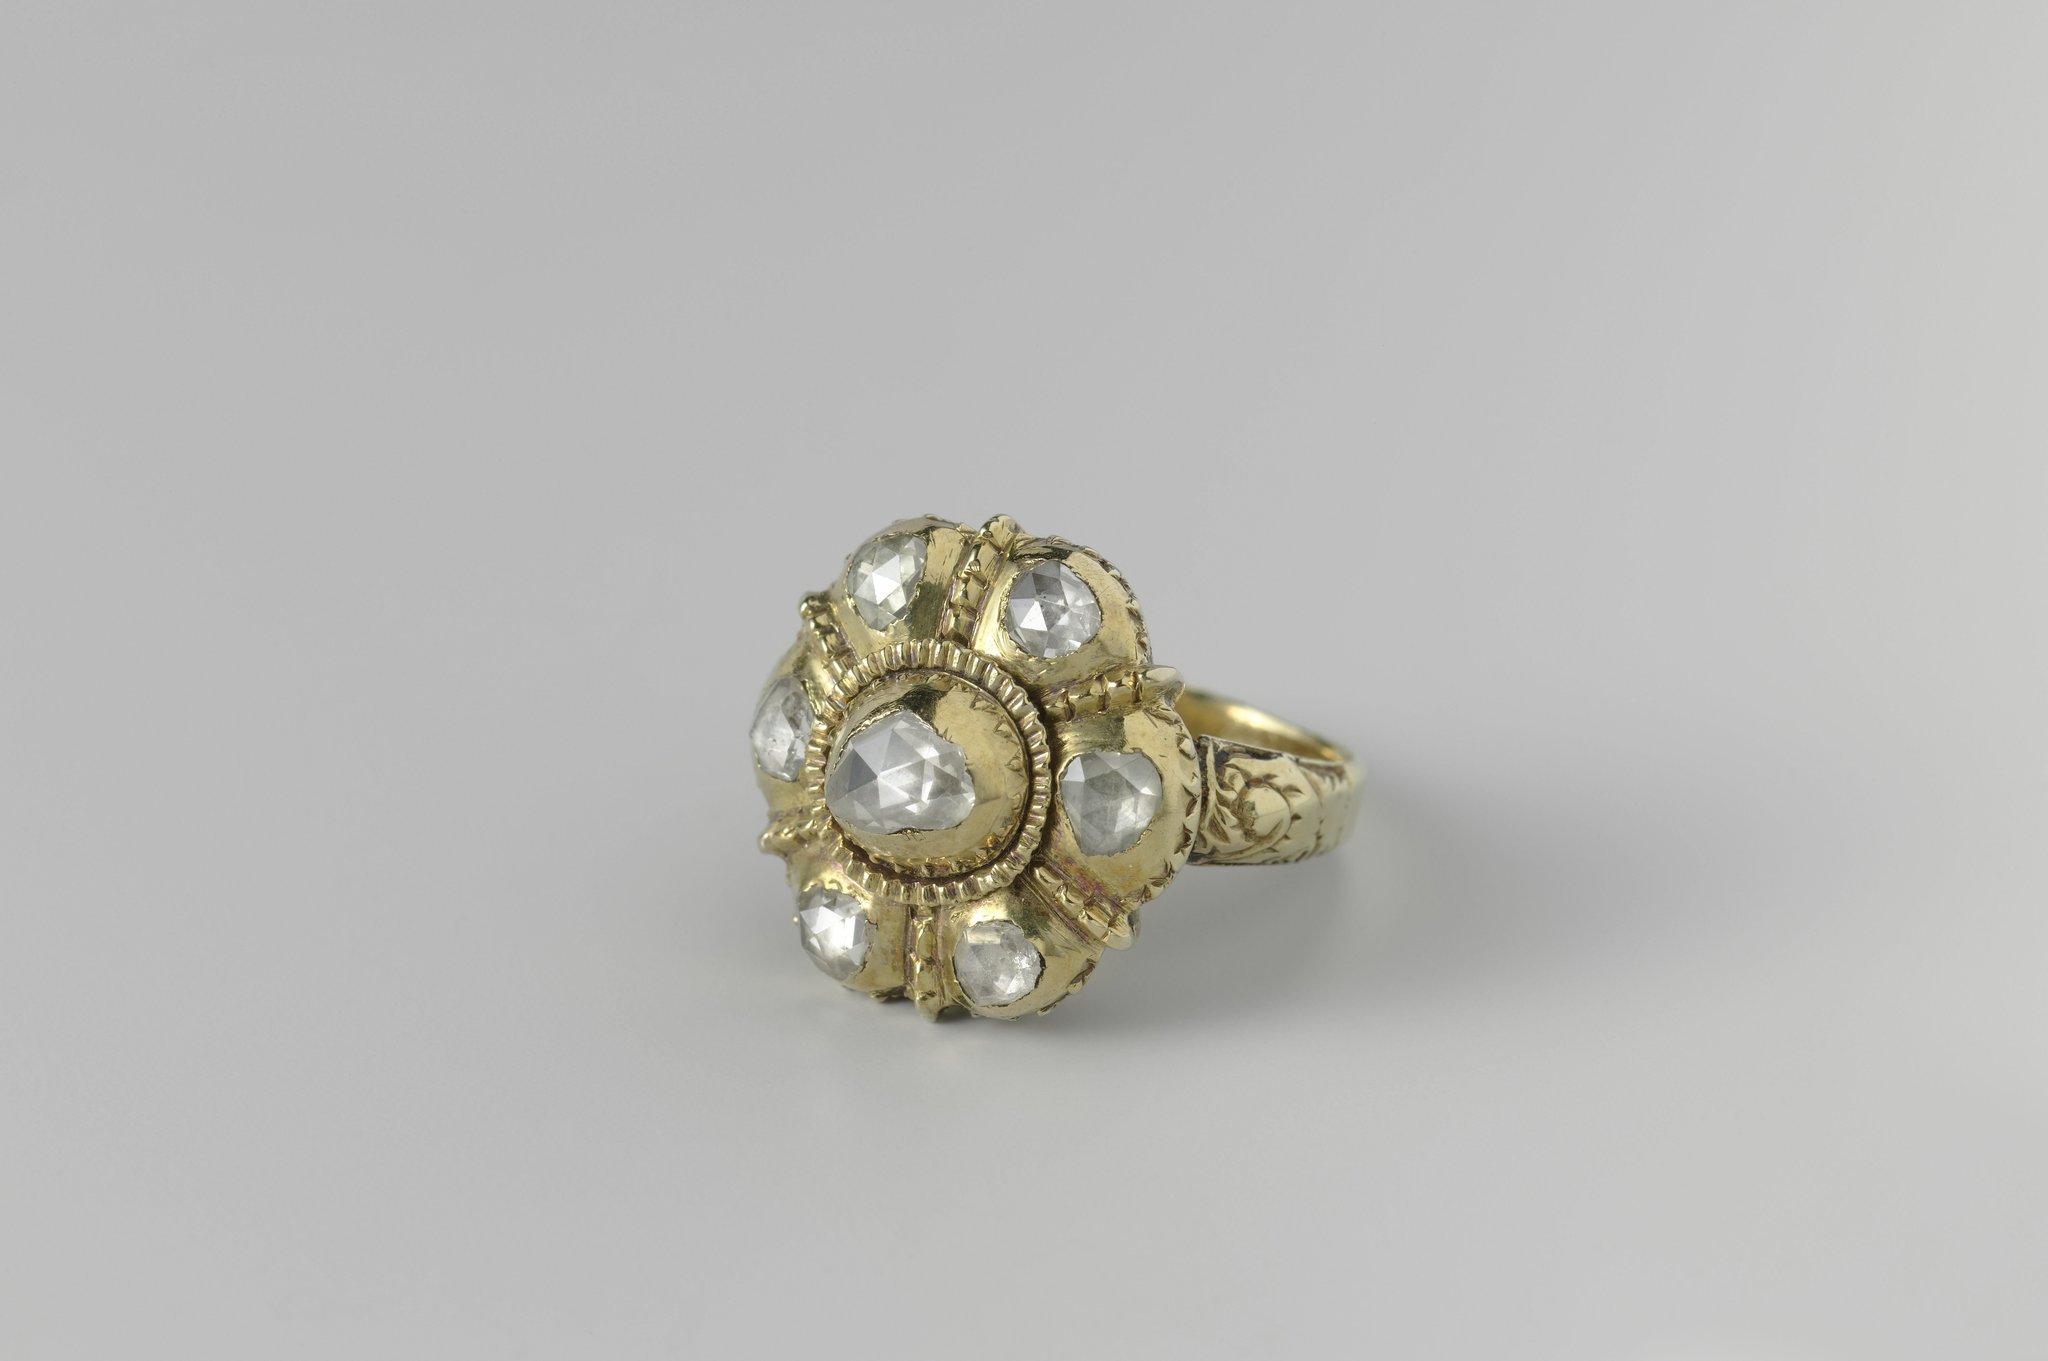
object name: ring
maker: Anonymous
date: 1670-1690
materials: diamond, gold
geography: netherlands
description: Ring van zilver of goud. In het midden een grote geslepen steen, daaromheen zes kleinere.